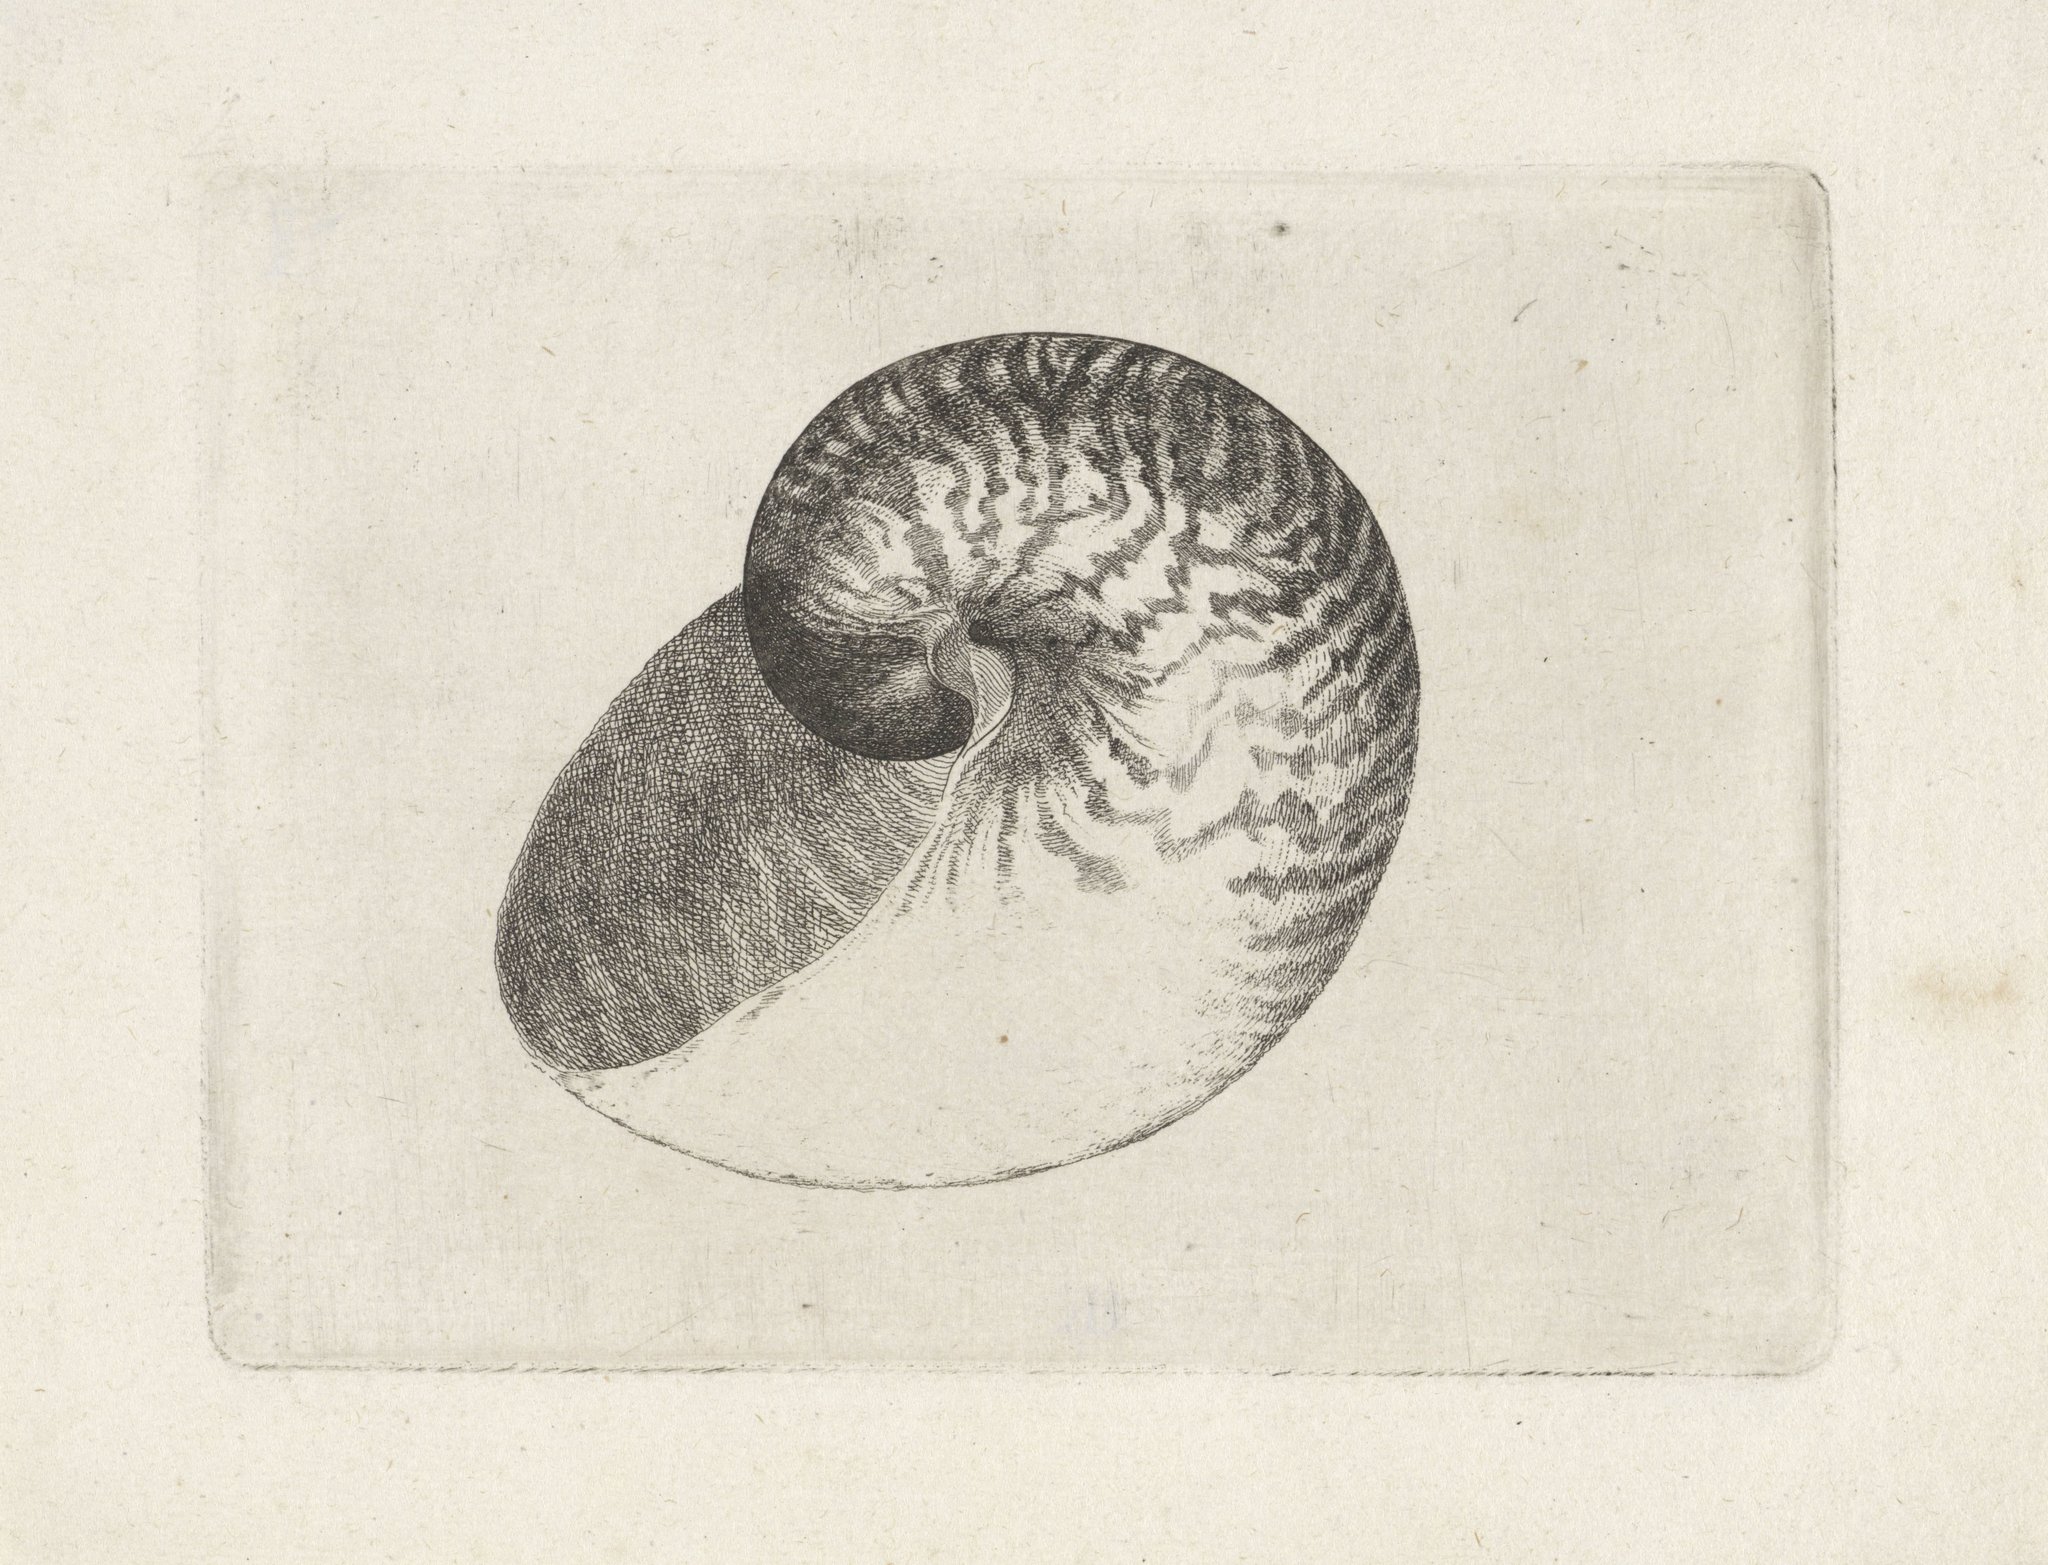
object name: print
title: Schelp, nautilus pompilius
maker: wenceslaus hollar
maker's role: draughtsman, print maker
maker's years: 1607-1677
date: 1644-1652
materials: paper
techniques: etching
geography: antwerp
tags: molluscs (+ shell, snail-shell etc.)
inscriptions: collector's mark: Lugt 68, collector's mark: Lugt 654, collector's mark: Lugt 384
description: Prent maakt deel uit van een 39-delige serie met verschillende soorten schelpen.